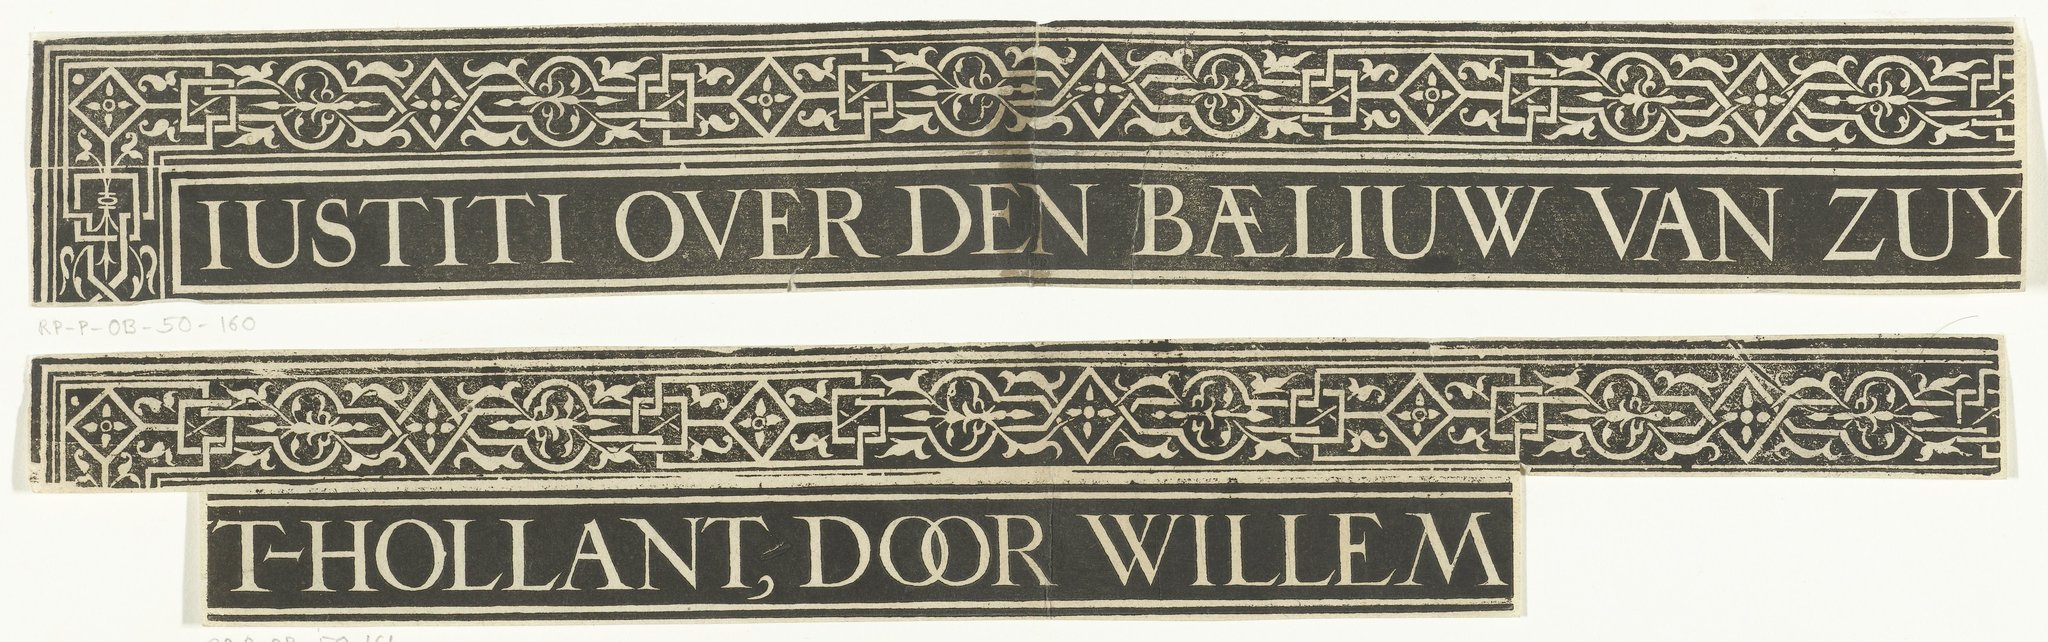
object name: print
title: Iustiti over den baeliuw van Zuyt-Hollant, door Willem de Goede, graef van Hollandt etc.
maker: Anonymous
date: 1613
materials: paper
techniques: woodcut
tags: willem iii de goede (graaf van holland en henegouwen)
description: Ornamentale rand met titel. Tweede van drie stroken tekst. Oorspronkelijk stond deze titel boven de grote centrale voorstelling in de prent van het verhaal van de Rechtspraak van graaf Willem III in het jaar 1336.